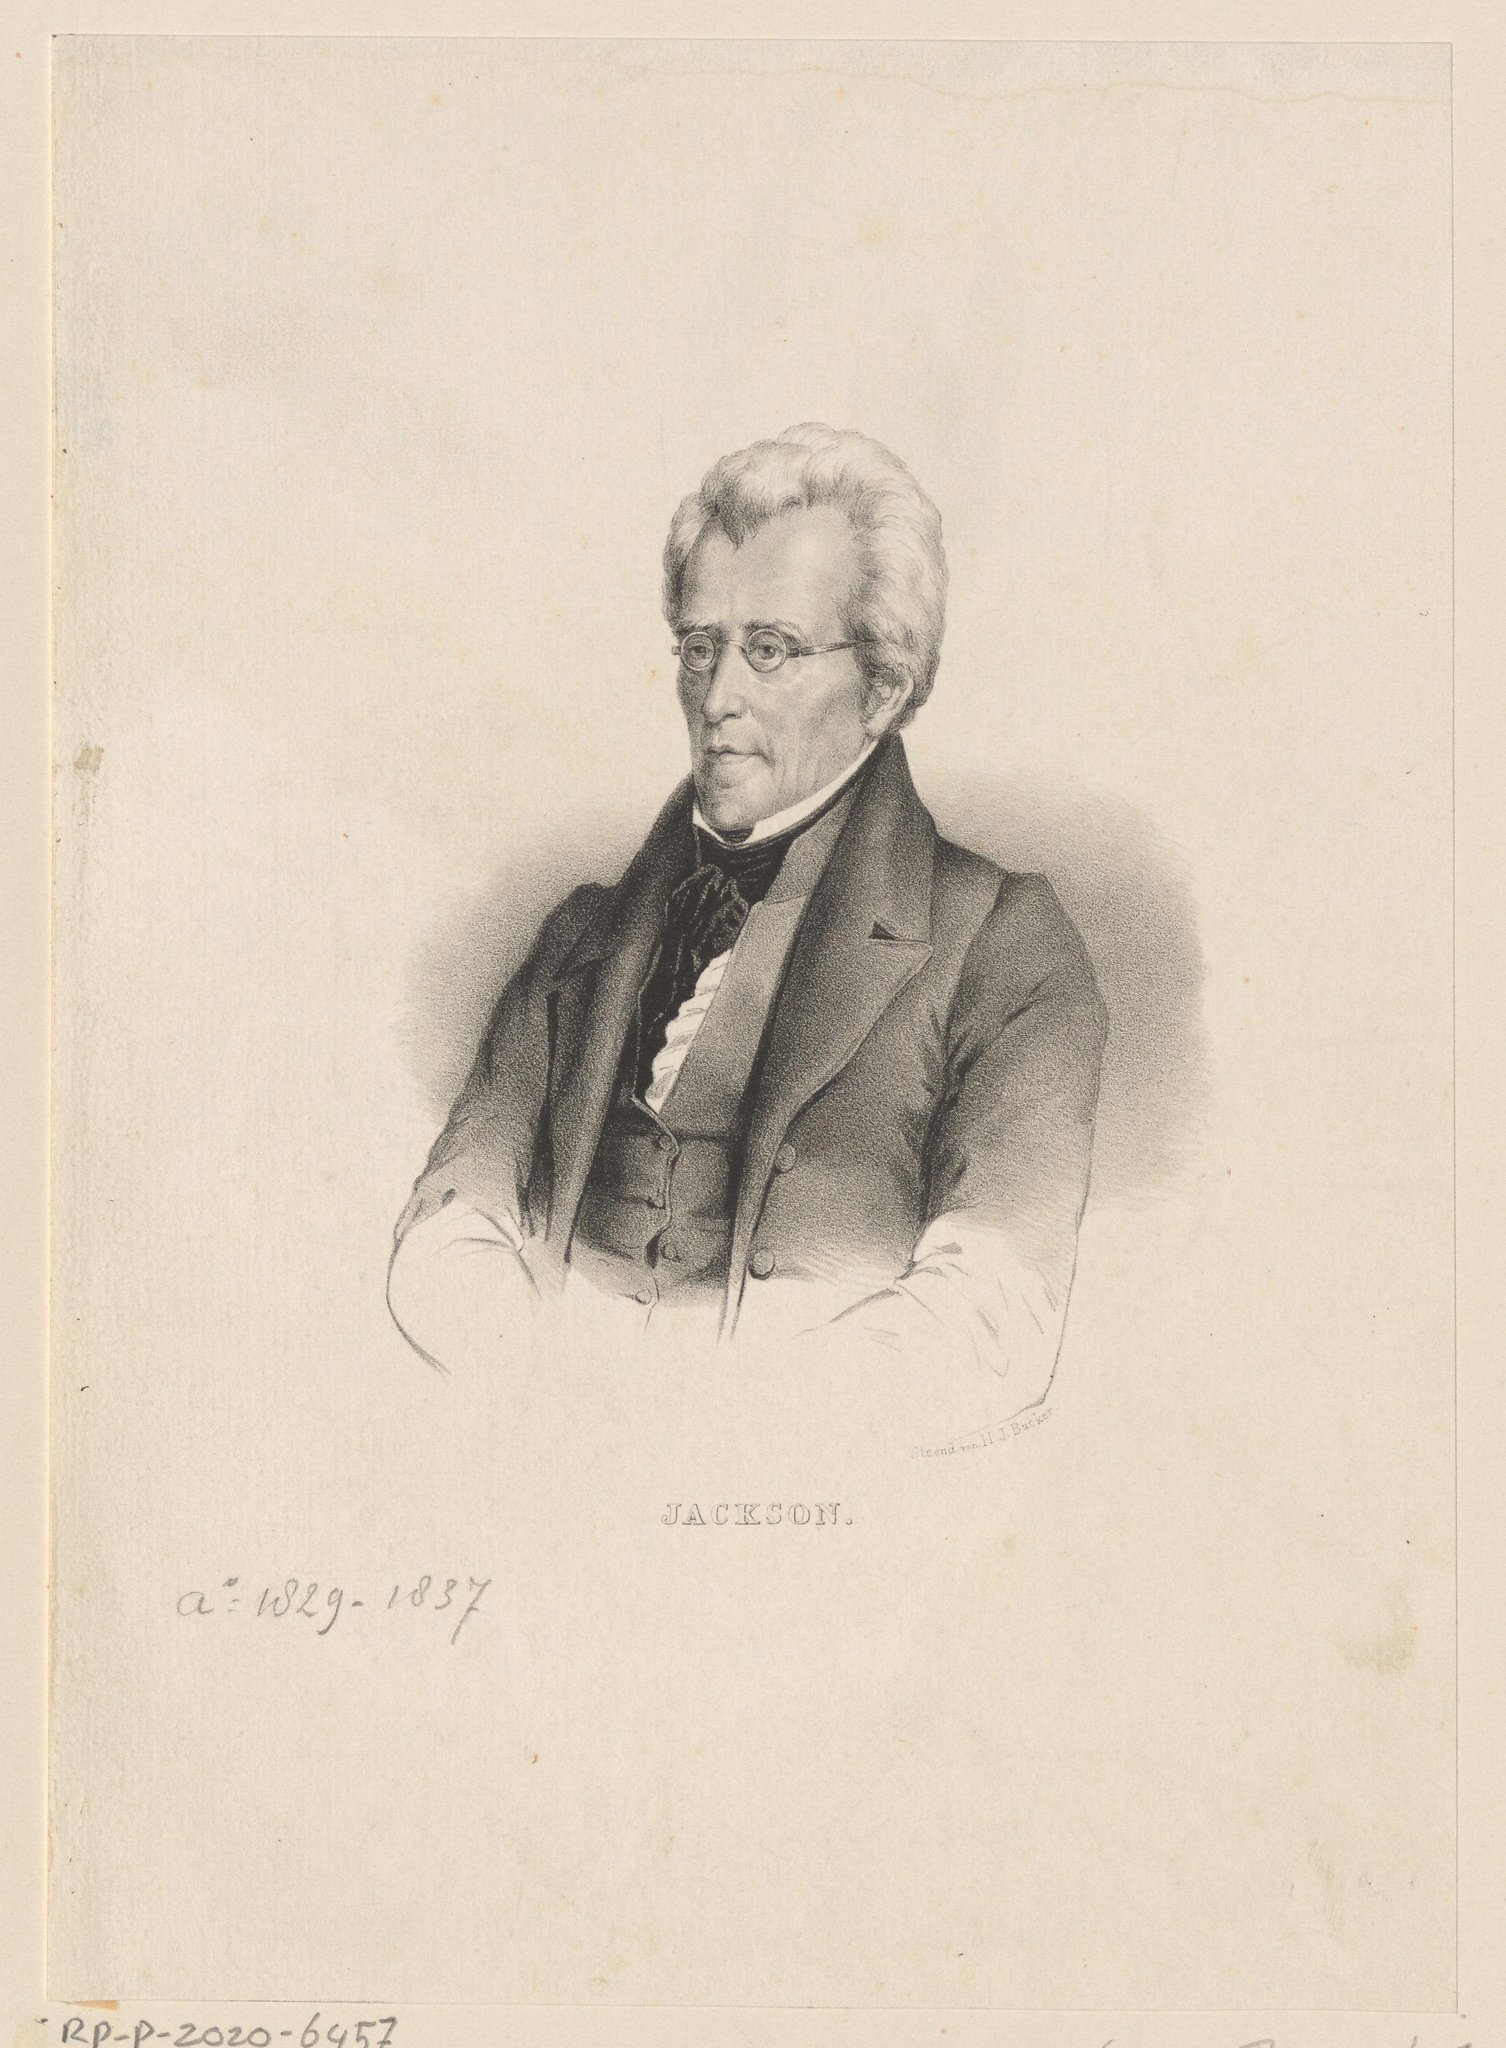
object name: print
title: Portret van Andrew Jackson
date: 1833-1845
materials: paper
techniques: lithograph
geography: dordrecht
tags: president ~ head of republic, historical persons